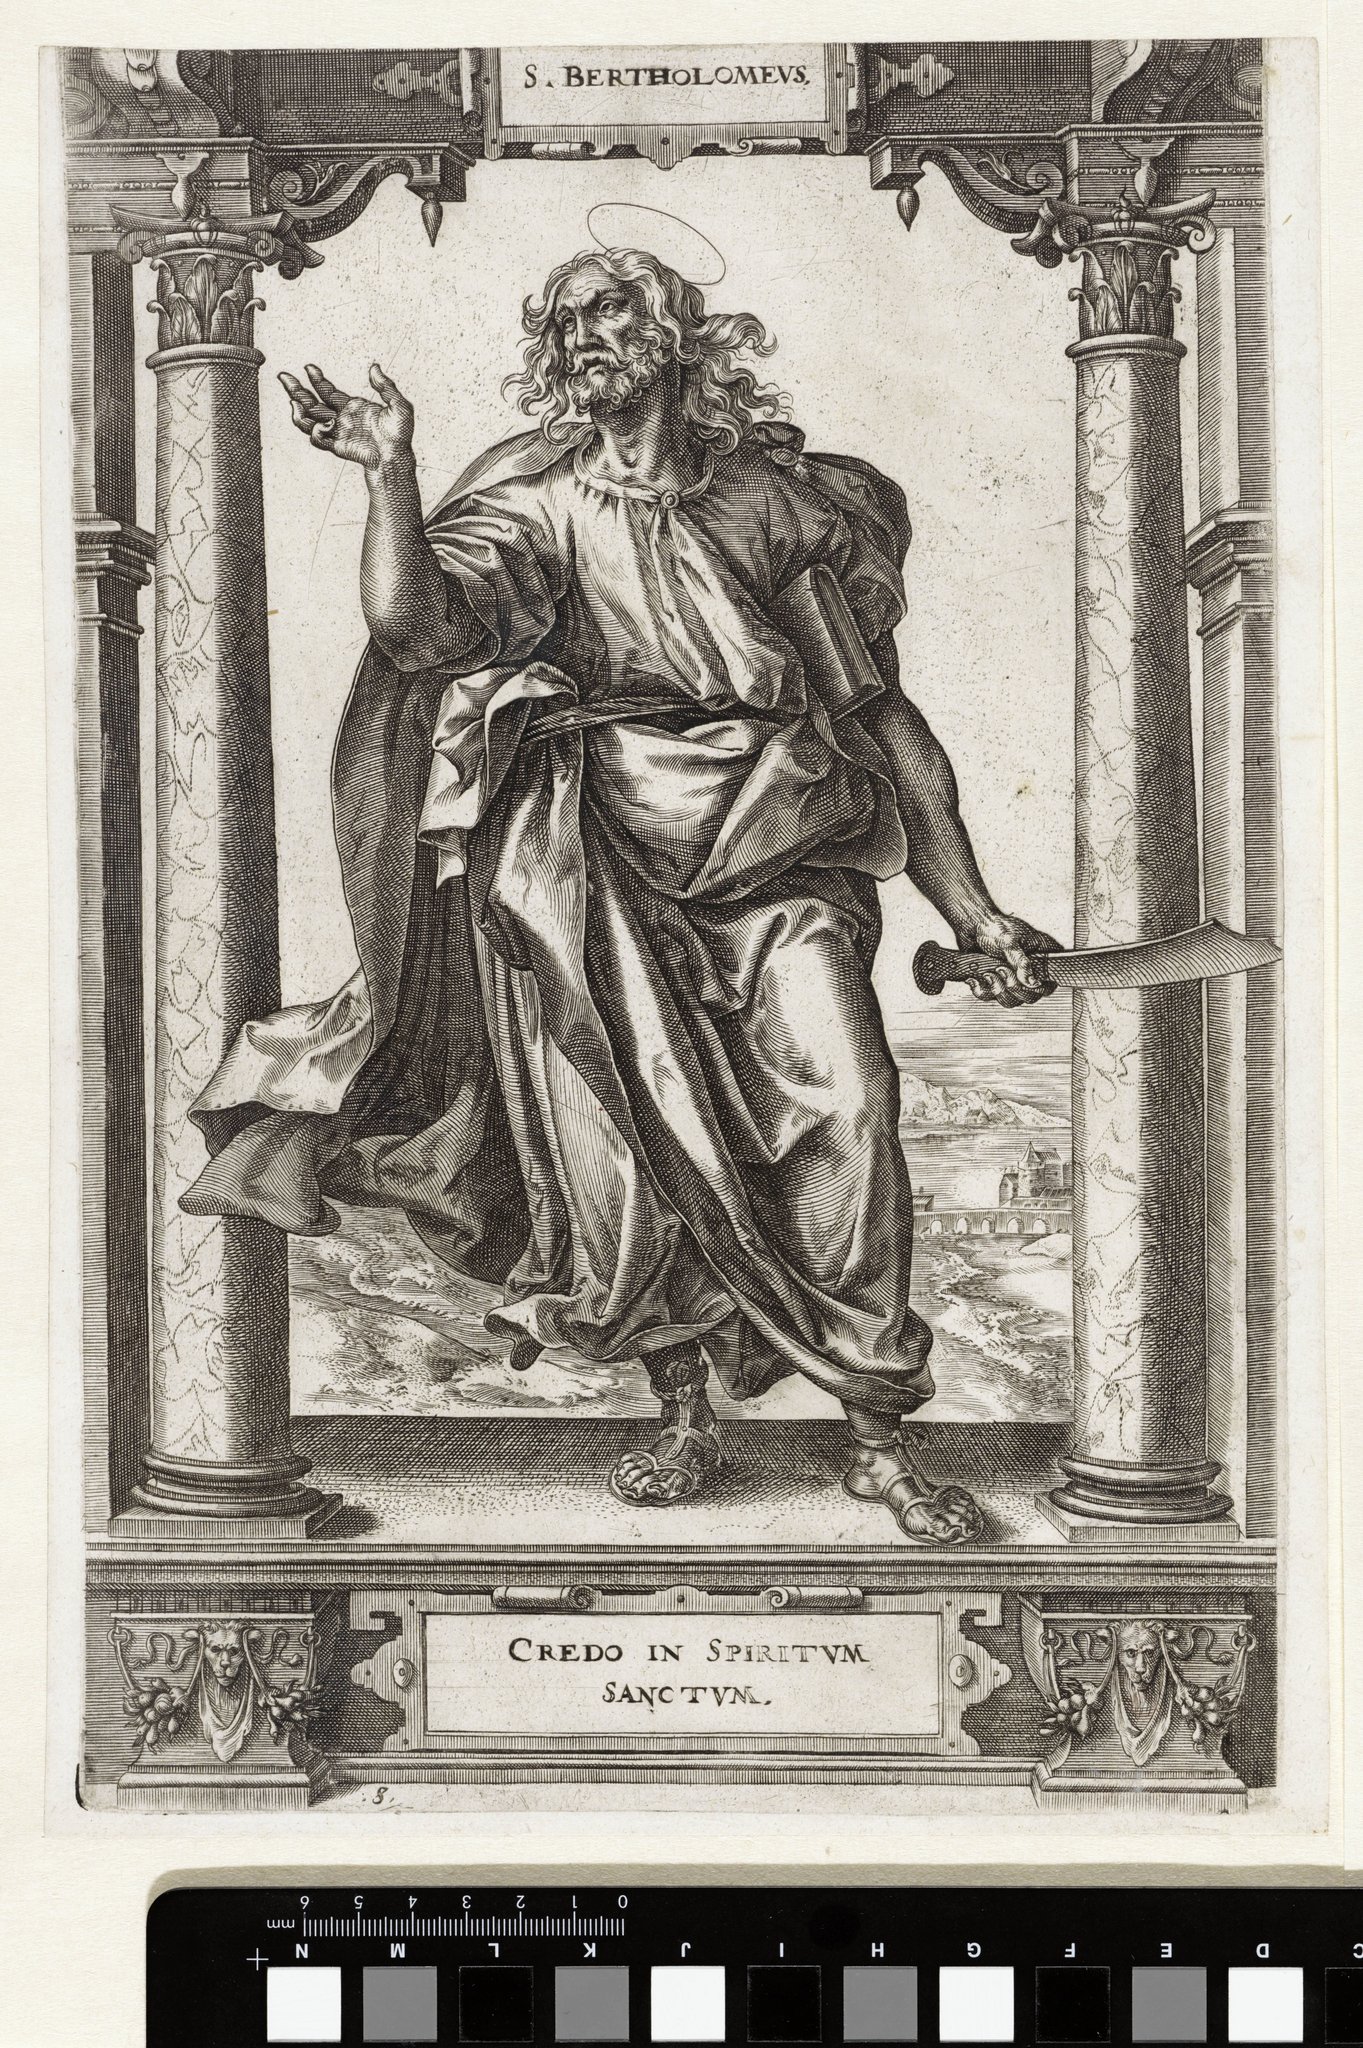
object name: print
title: H. Bartolomeüs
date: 1578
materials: paper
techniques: engraving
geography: antwerp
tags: the apostle bartholomew; possible attributes: book, devil or dragon at feet, knife, scroll, flayed skin, staff, column, pillar ~ architecture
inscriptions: collector's mark: Lugt 2228, collector's mark: Lugt 2760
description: De heilige Bartolomeüs staat tussen twee zuilen in een architecturale omlijsting. Onder zijn arm houdt hij een boek, in zijn hand een mes. Op de achtergrond een gezicht op een heuvelachtig landschap. In het kader onderaan een tweeregelig onderschrift in het Latijn.